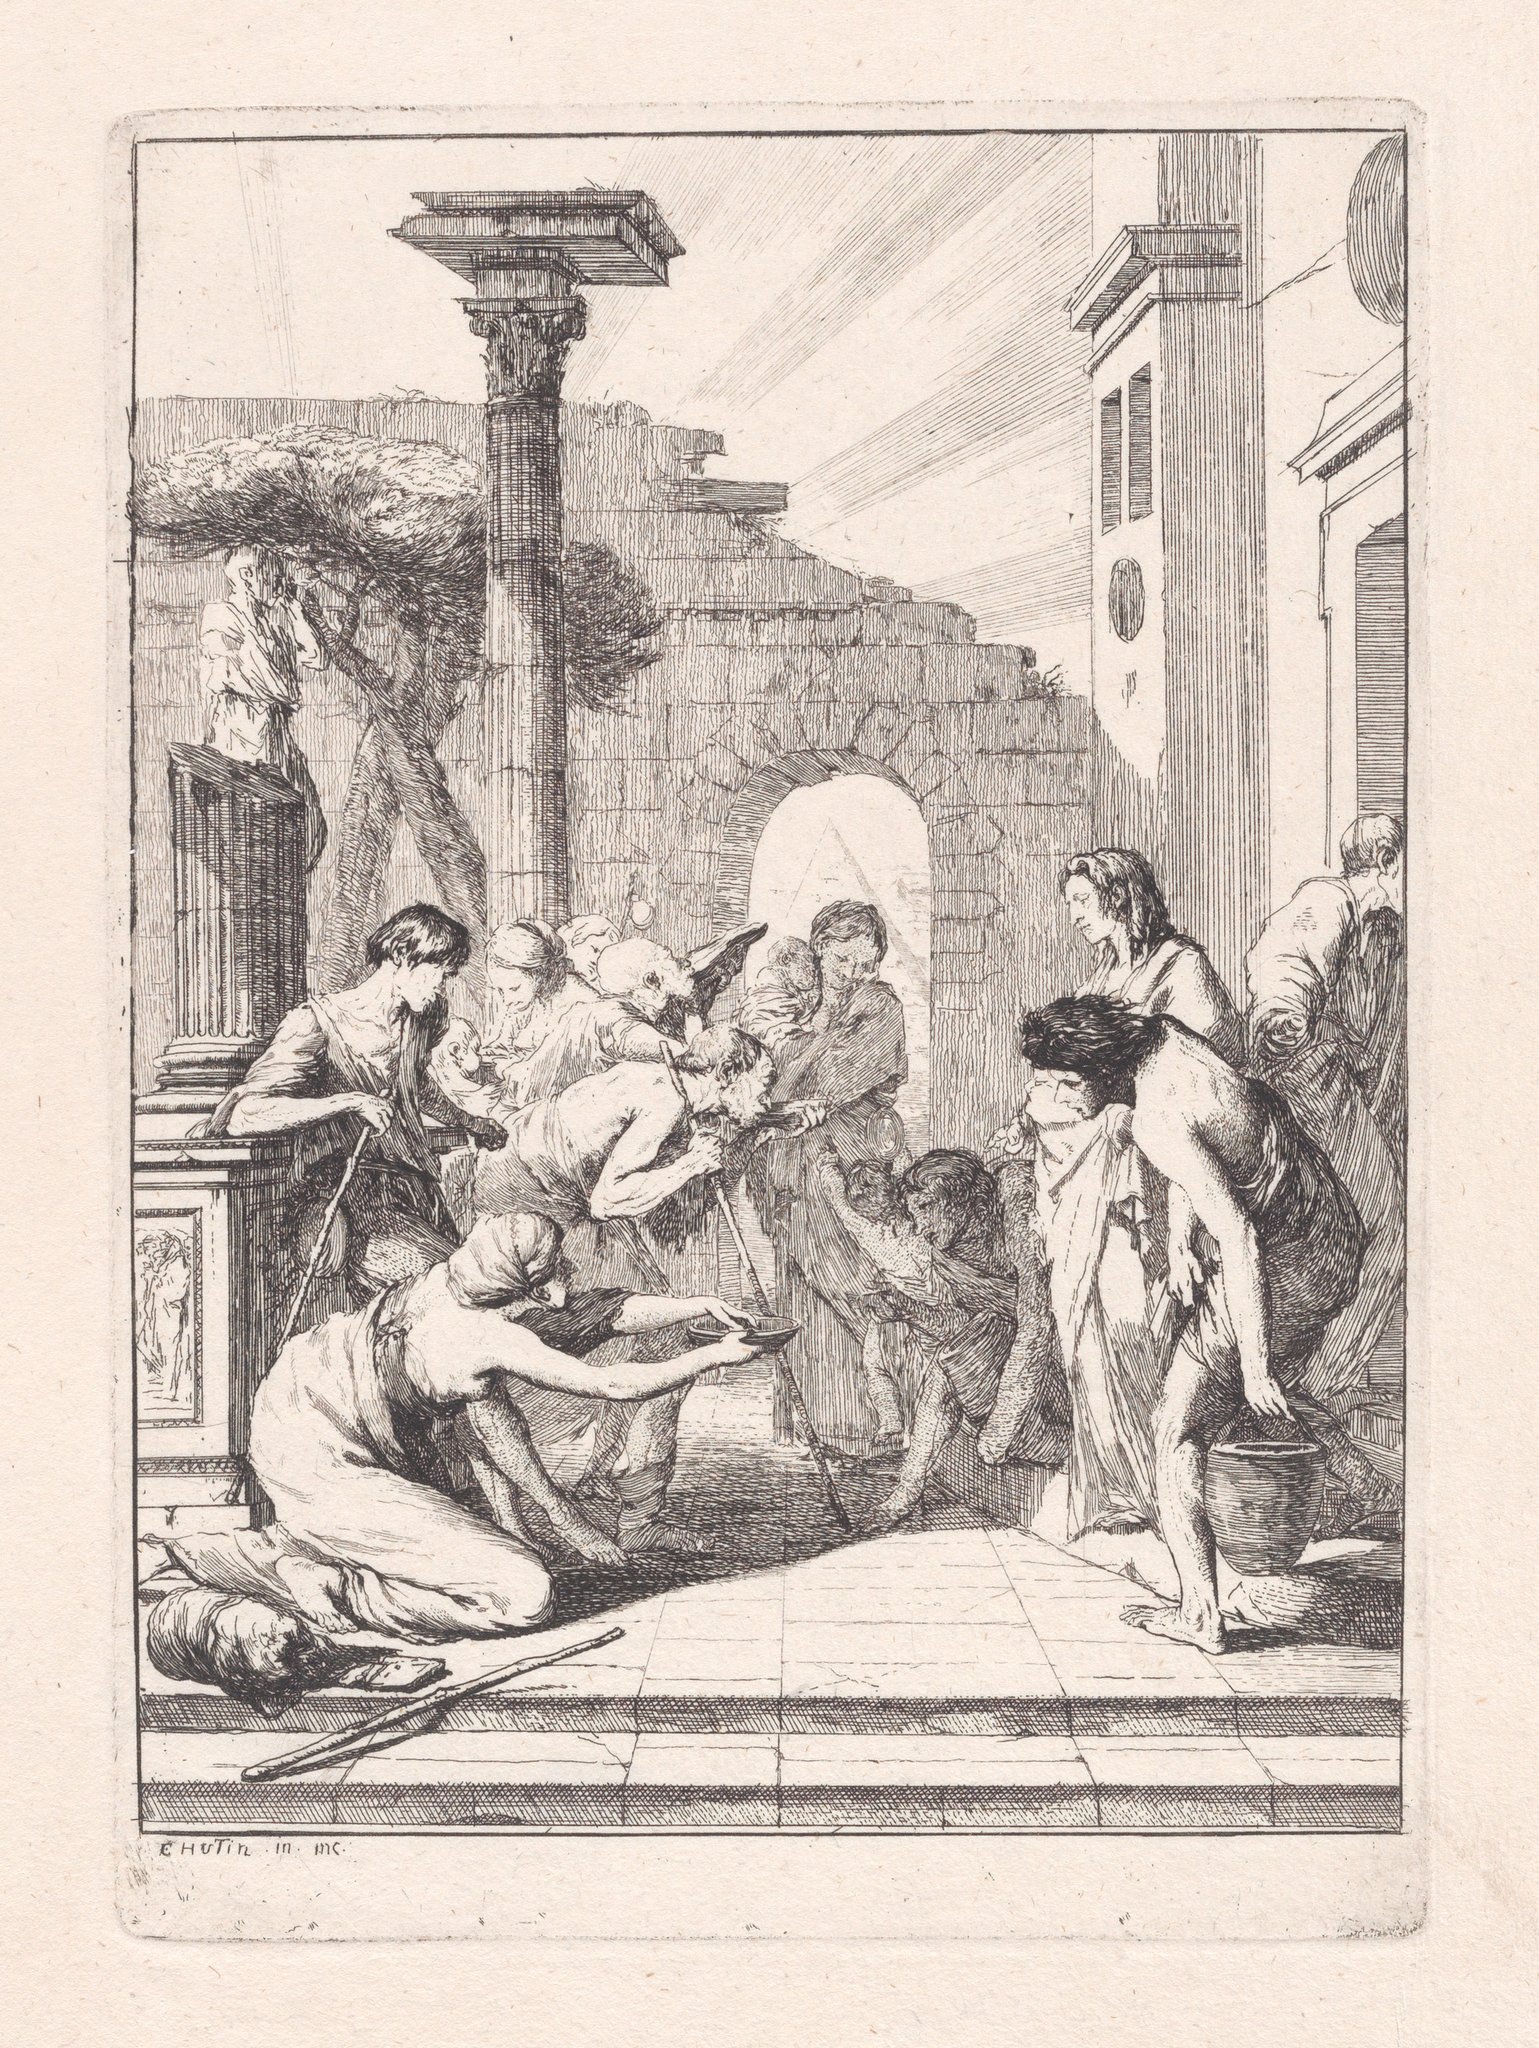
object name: print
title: Giving Drink to the Thirsty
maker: françois hutin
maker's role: artist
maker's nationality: french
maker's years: 1686-1758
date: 1737-1742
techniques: etching